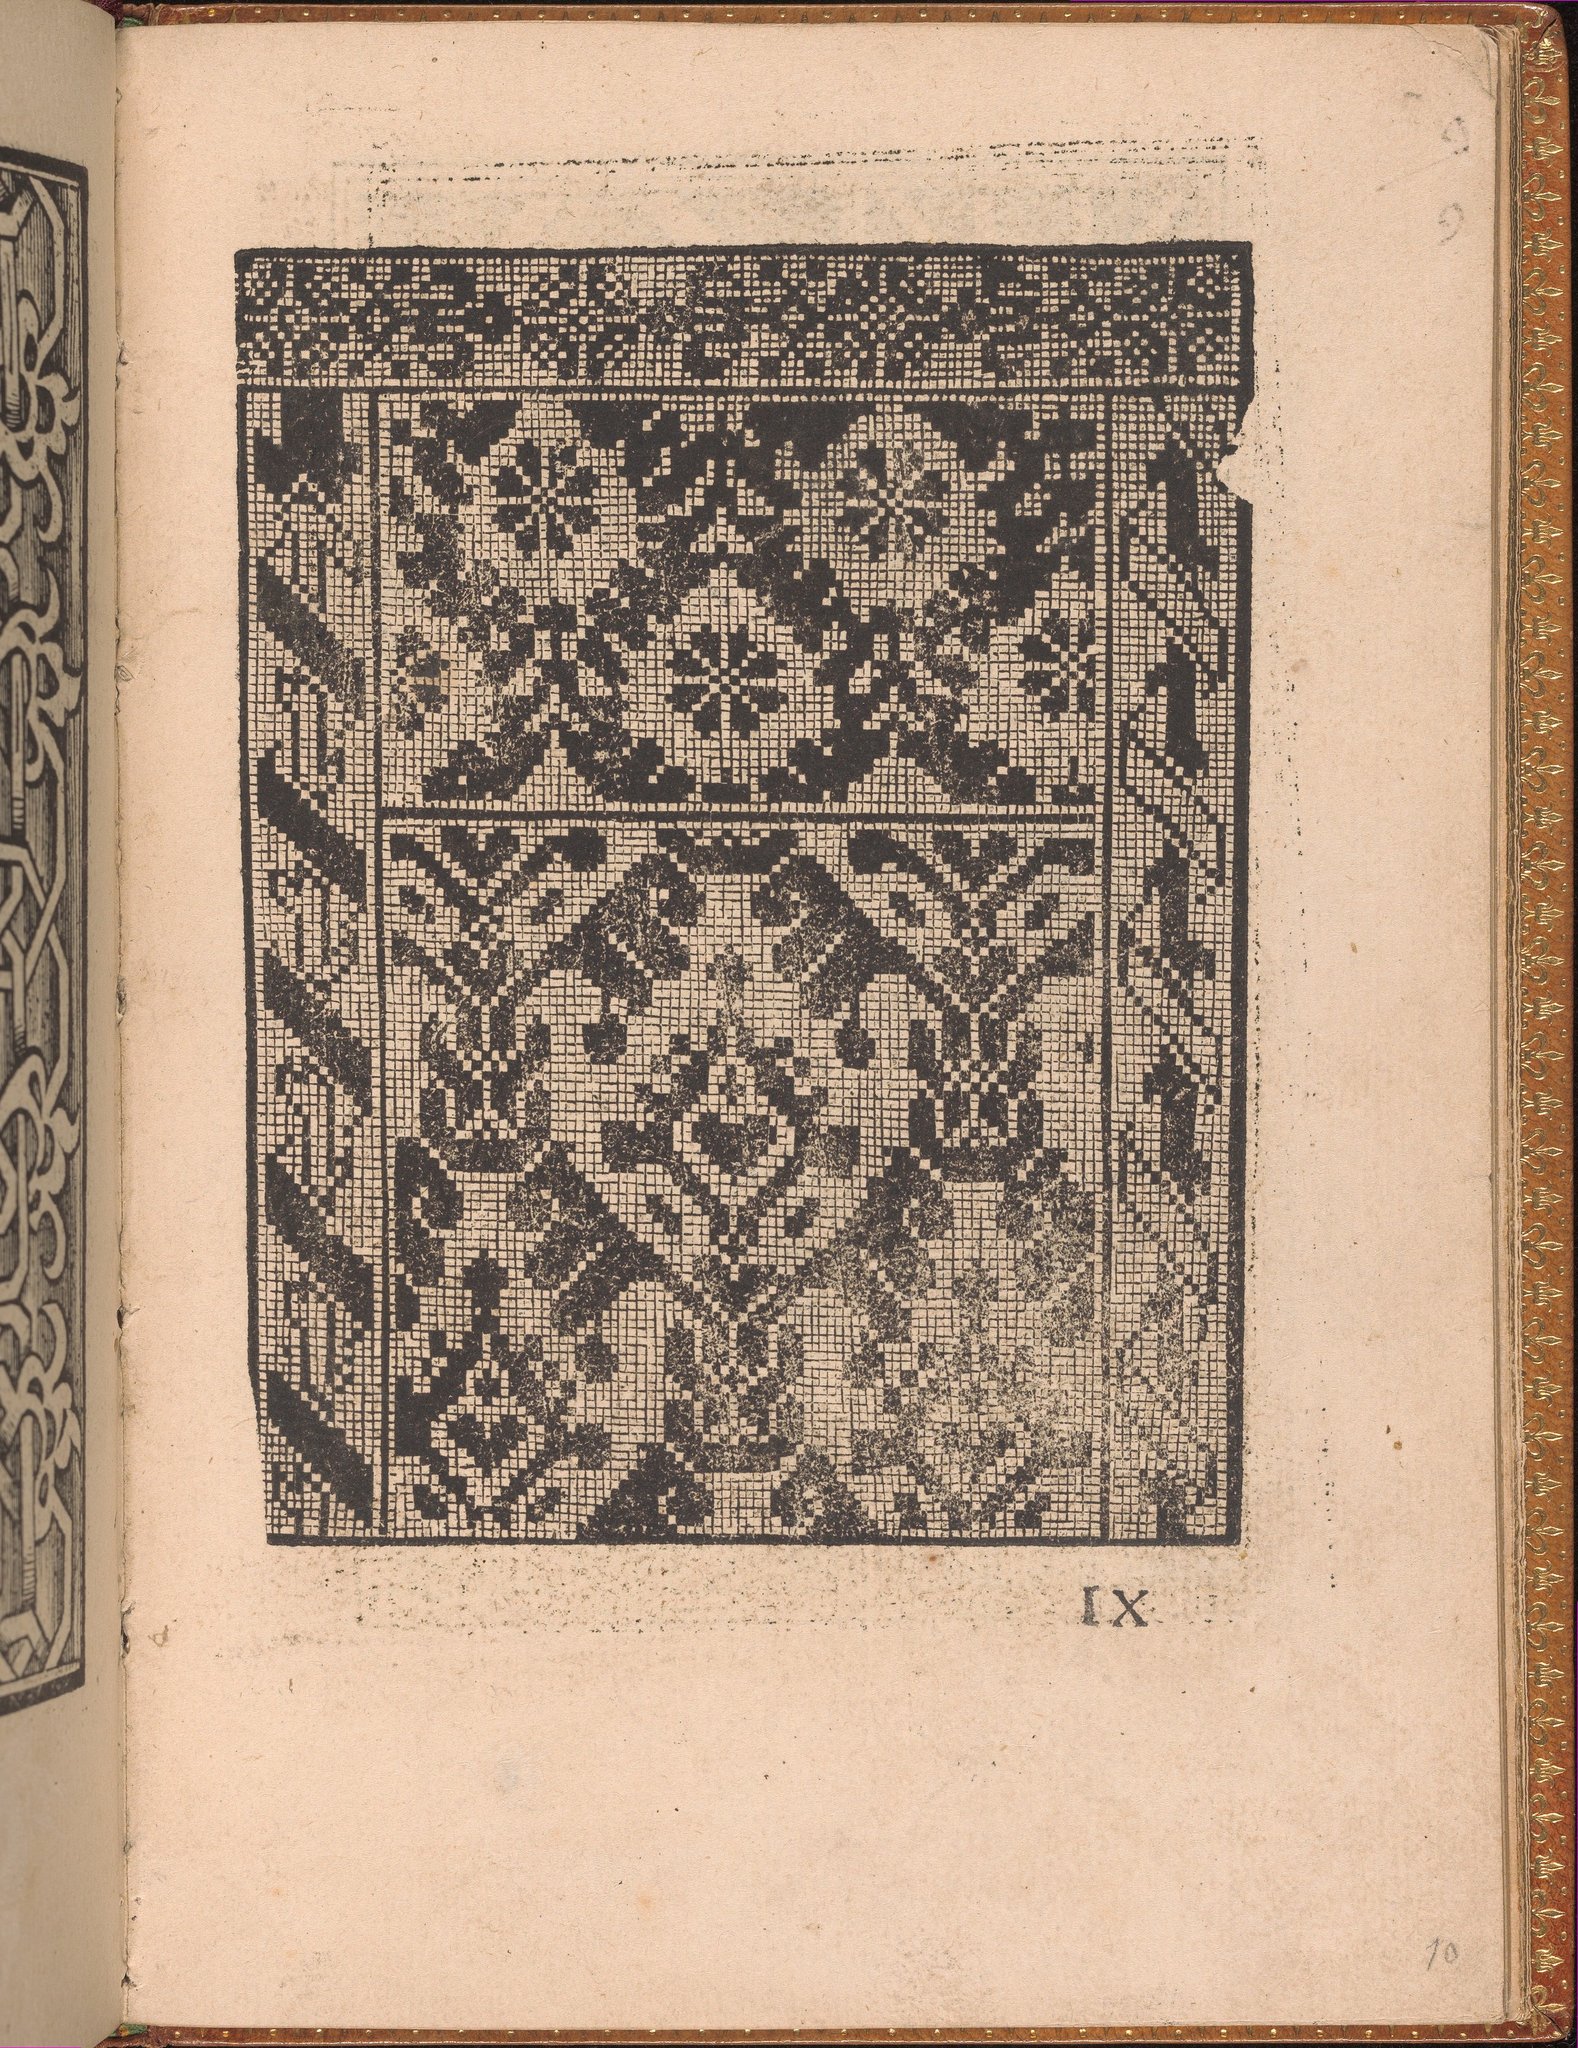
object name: book print ornament architecture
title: Convivio delle Belle Donne, page 10 (recto)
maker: nicolò zoppino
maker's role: publisher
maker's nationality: italian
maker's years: 1478-1544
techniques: woodcut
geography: italy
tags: ornament